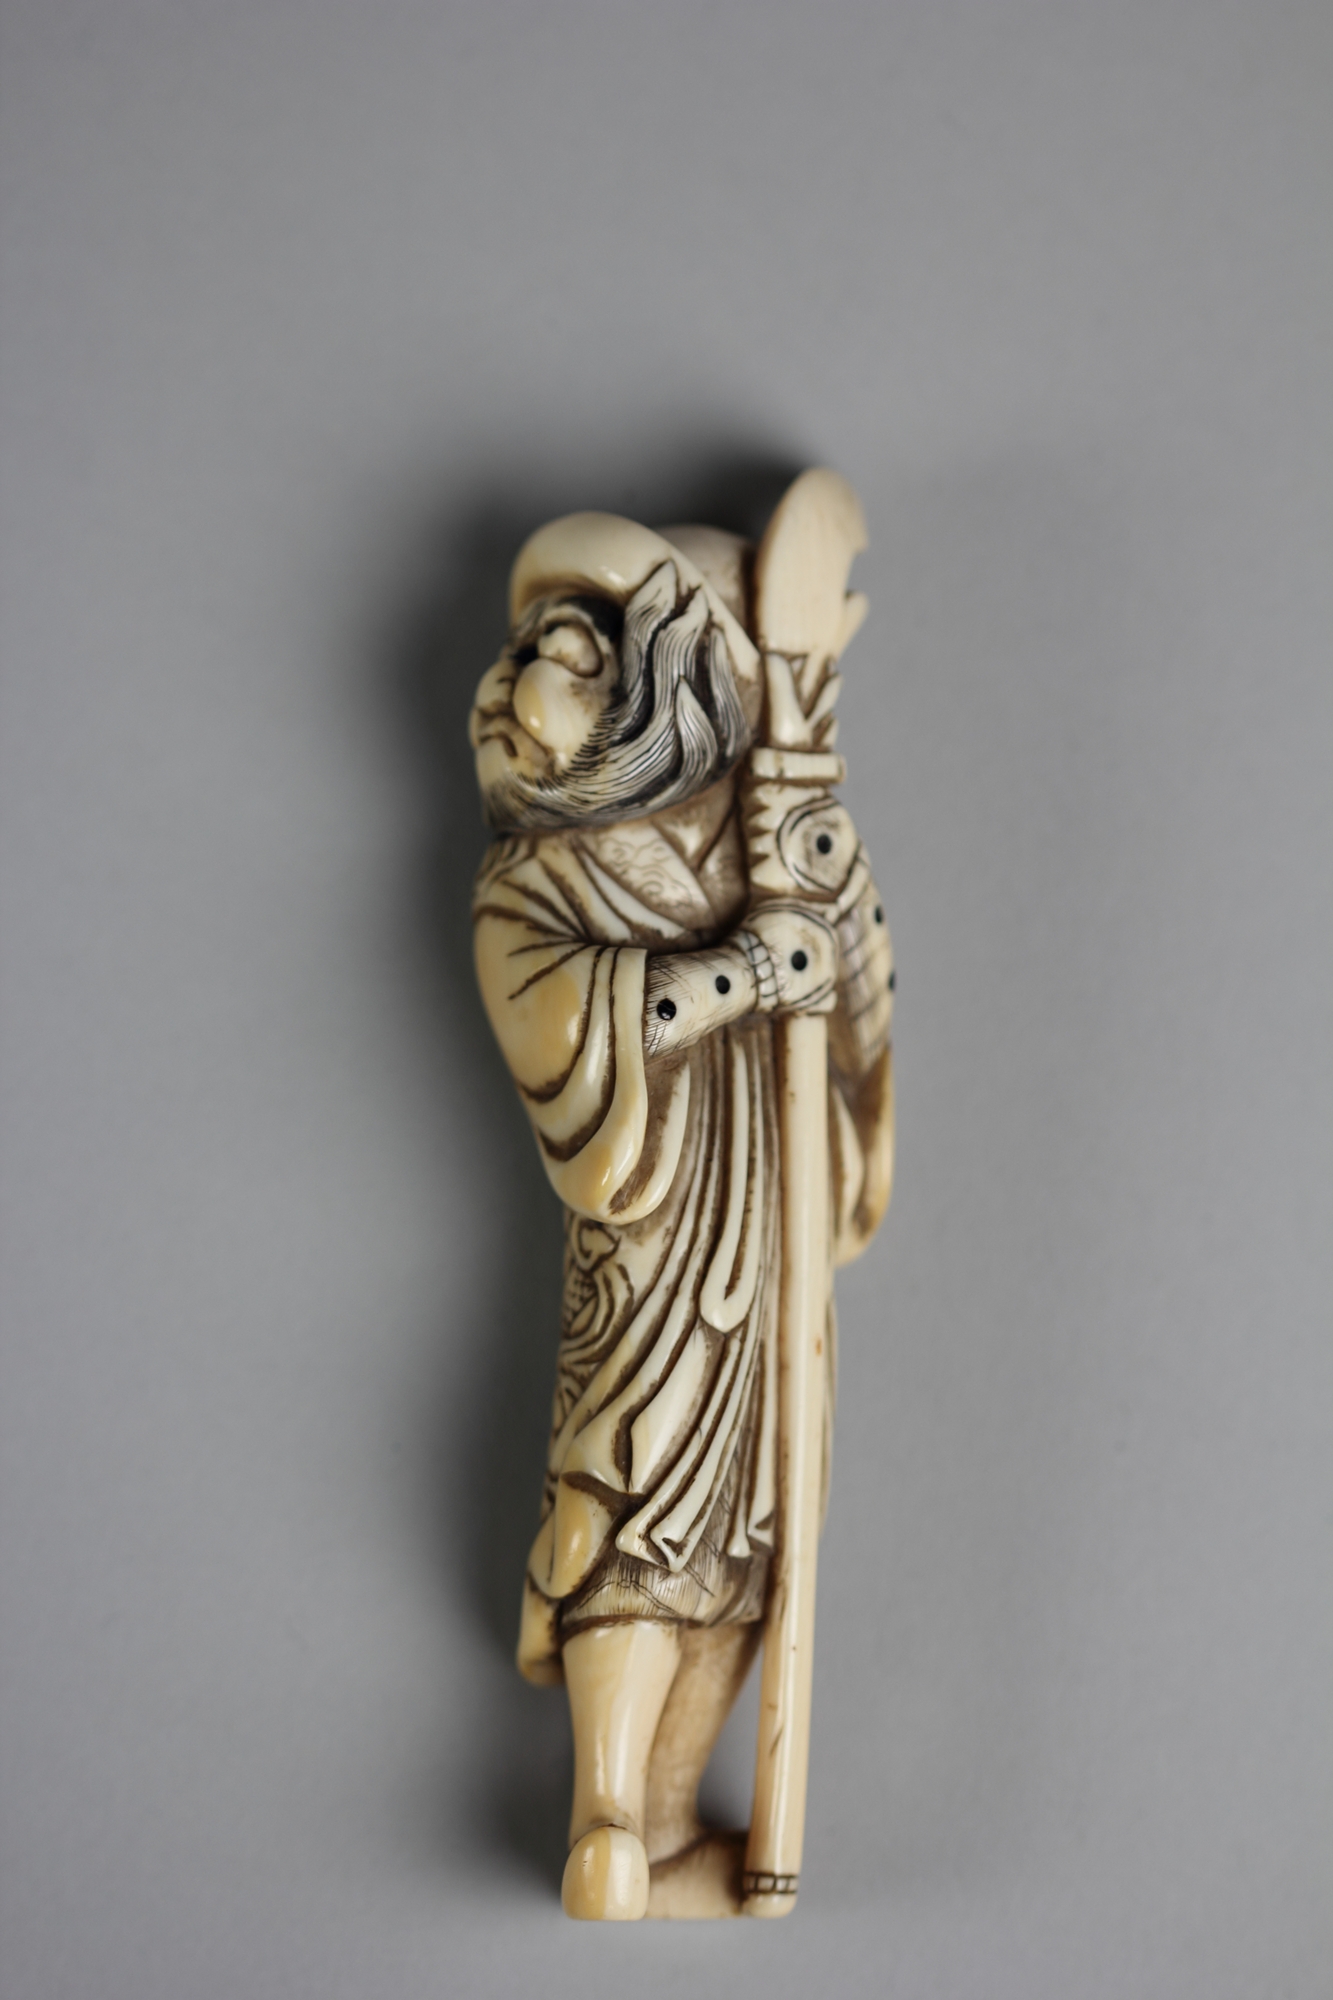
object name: netsuke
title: Netsuke of Large Masked Figure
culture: japanese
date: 1801-1900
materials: ivory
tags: human figures